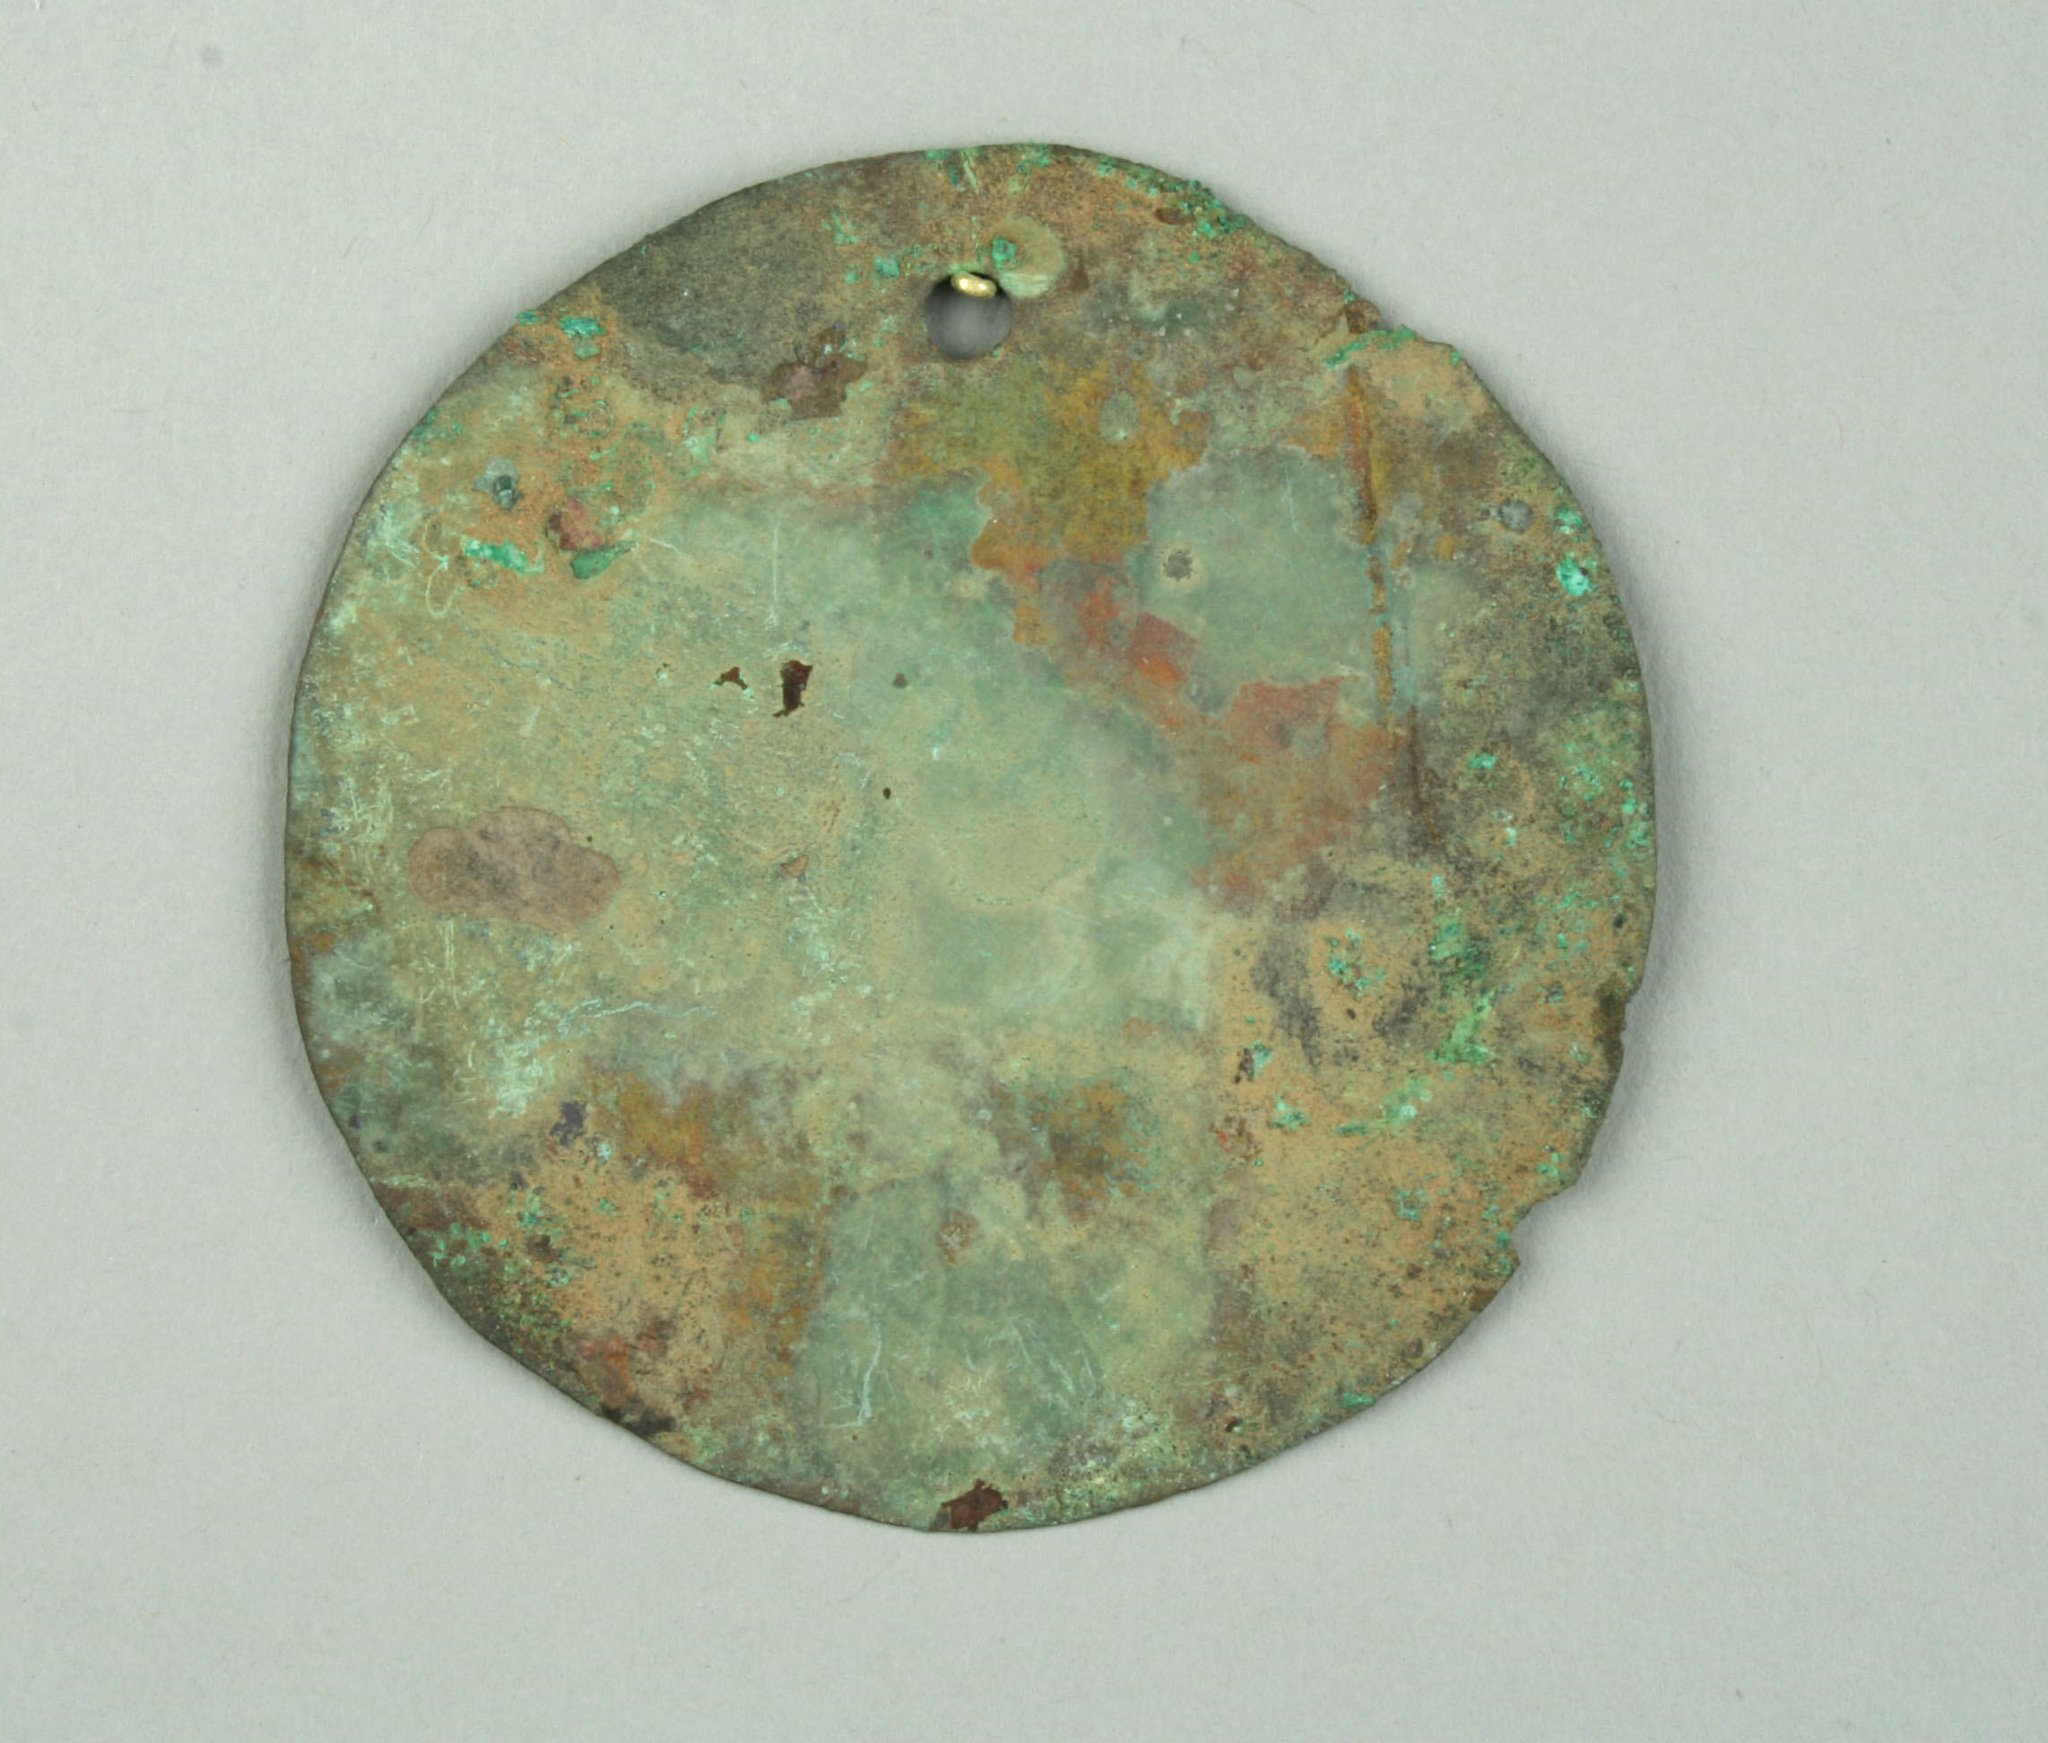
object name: plaque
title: Round Plaque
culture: vicús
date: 300 BCE-200 CE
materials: copper, gilt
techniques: hammering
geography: peru